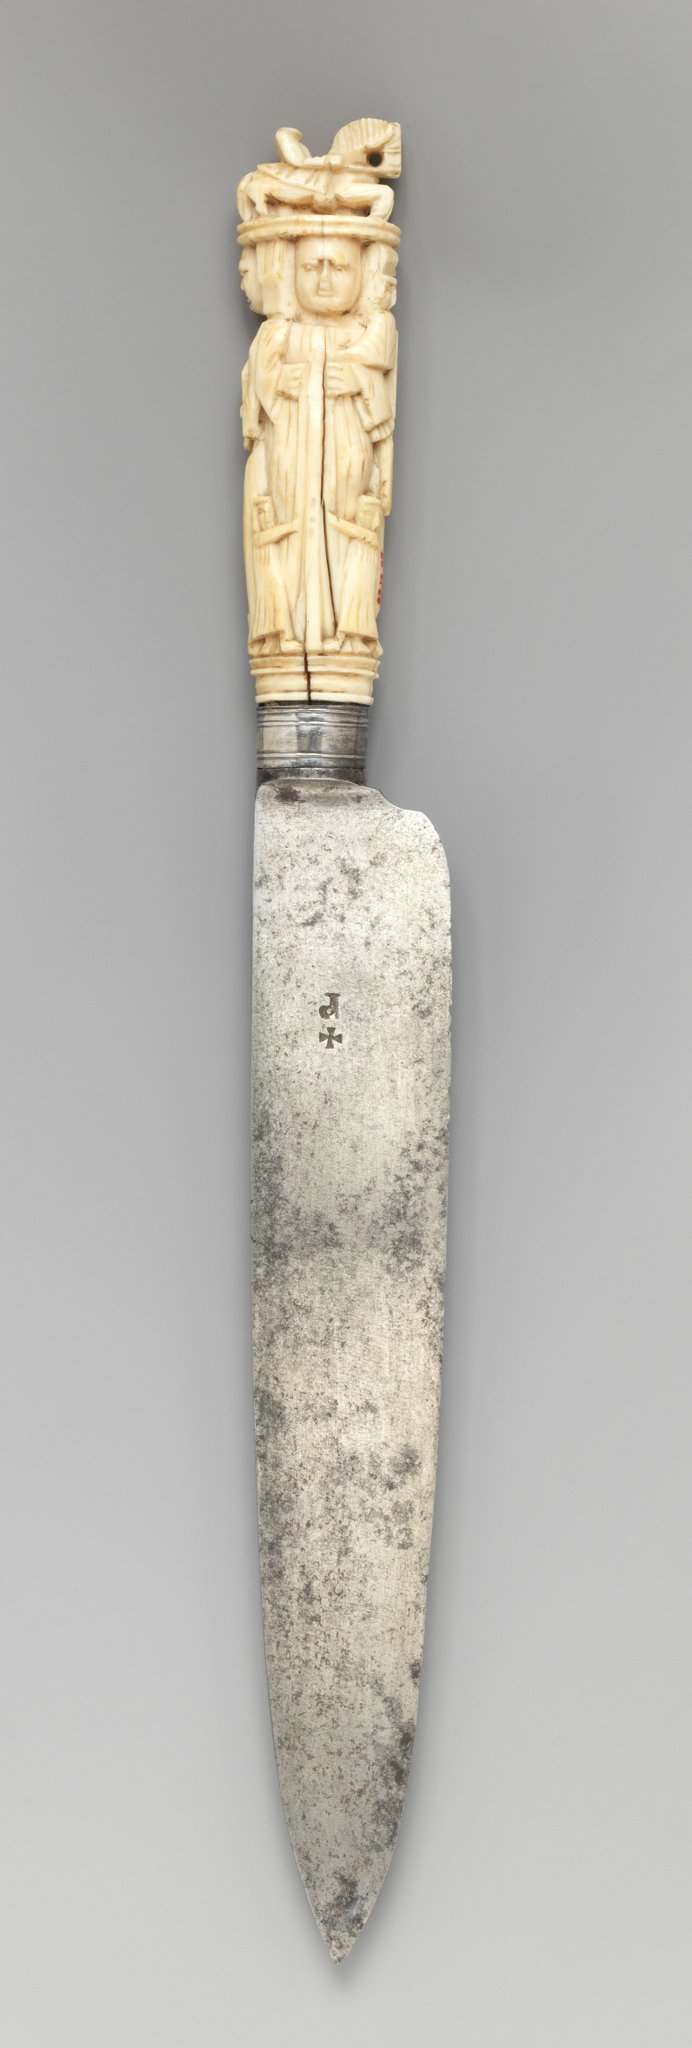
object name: knife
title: Carving knife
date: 1776-1800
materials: ivory, silver, steel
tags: men,women,horses